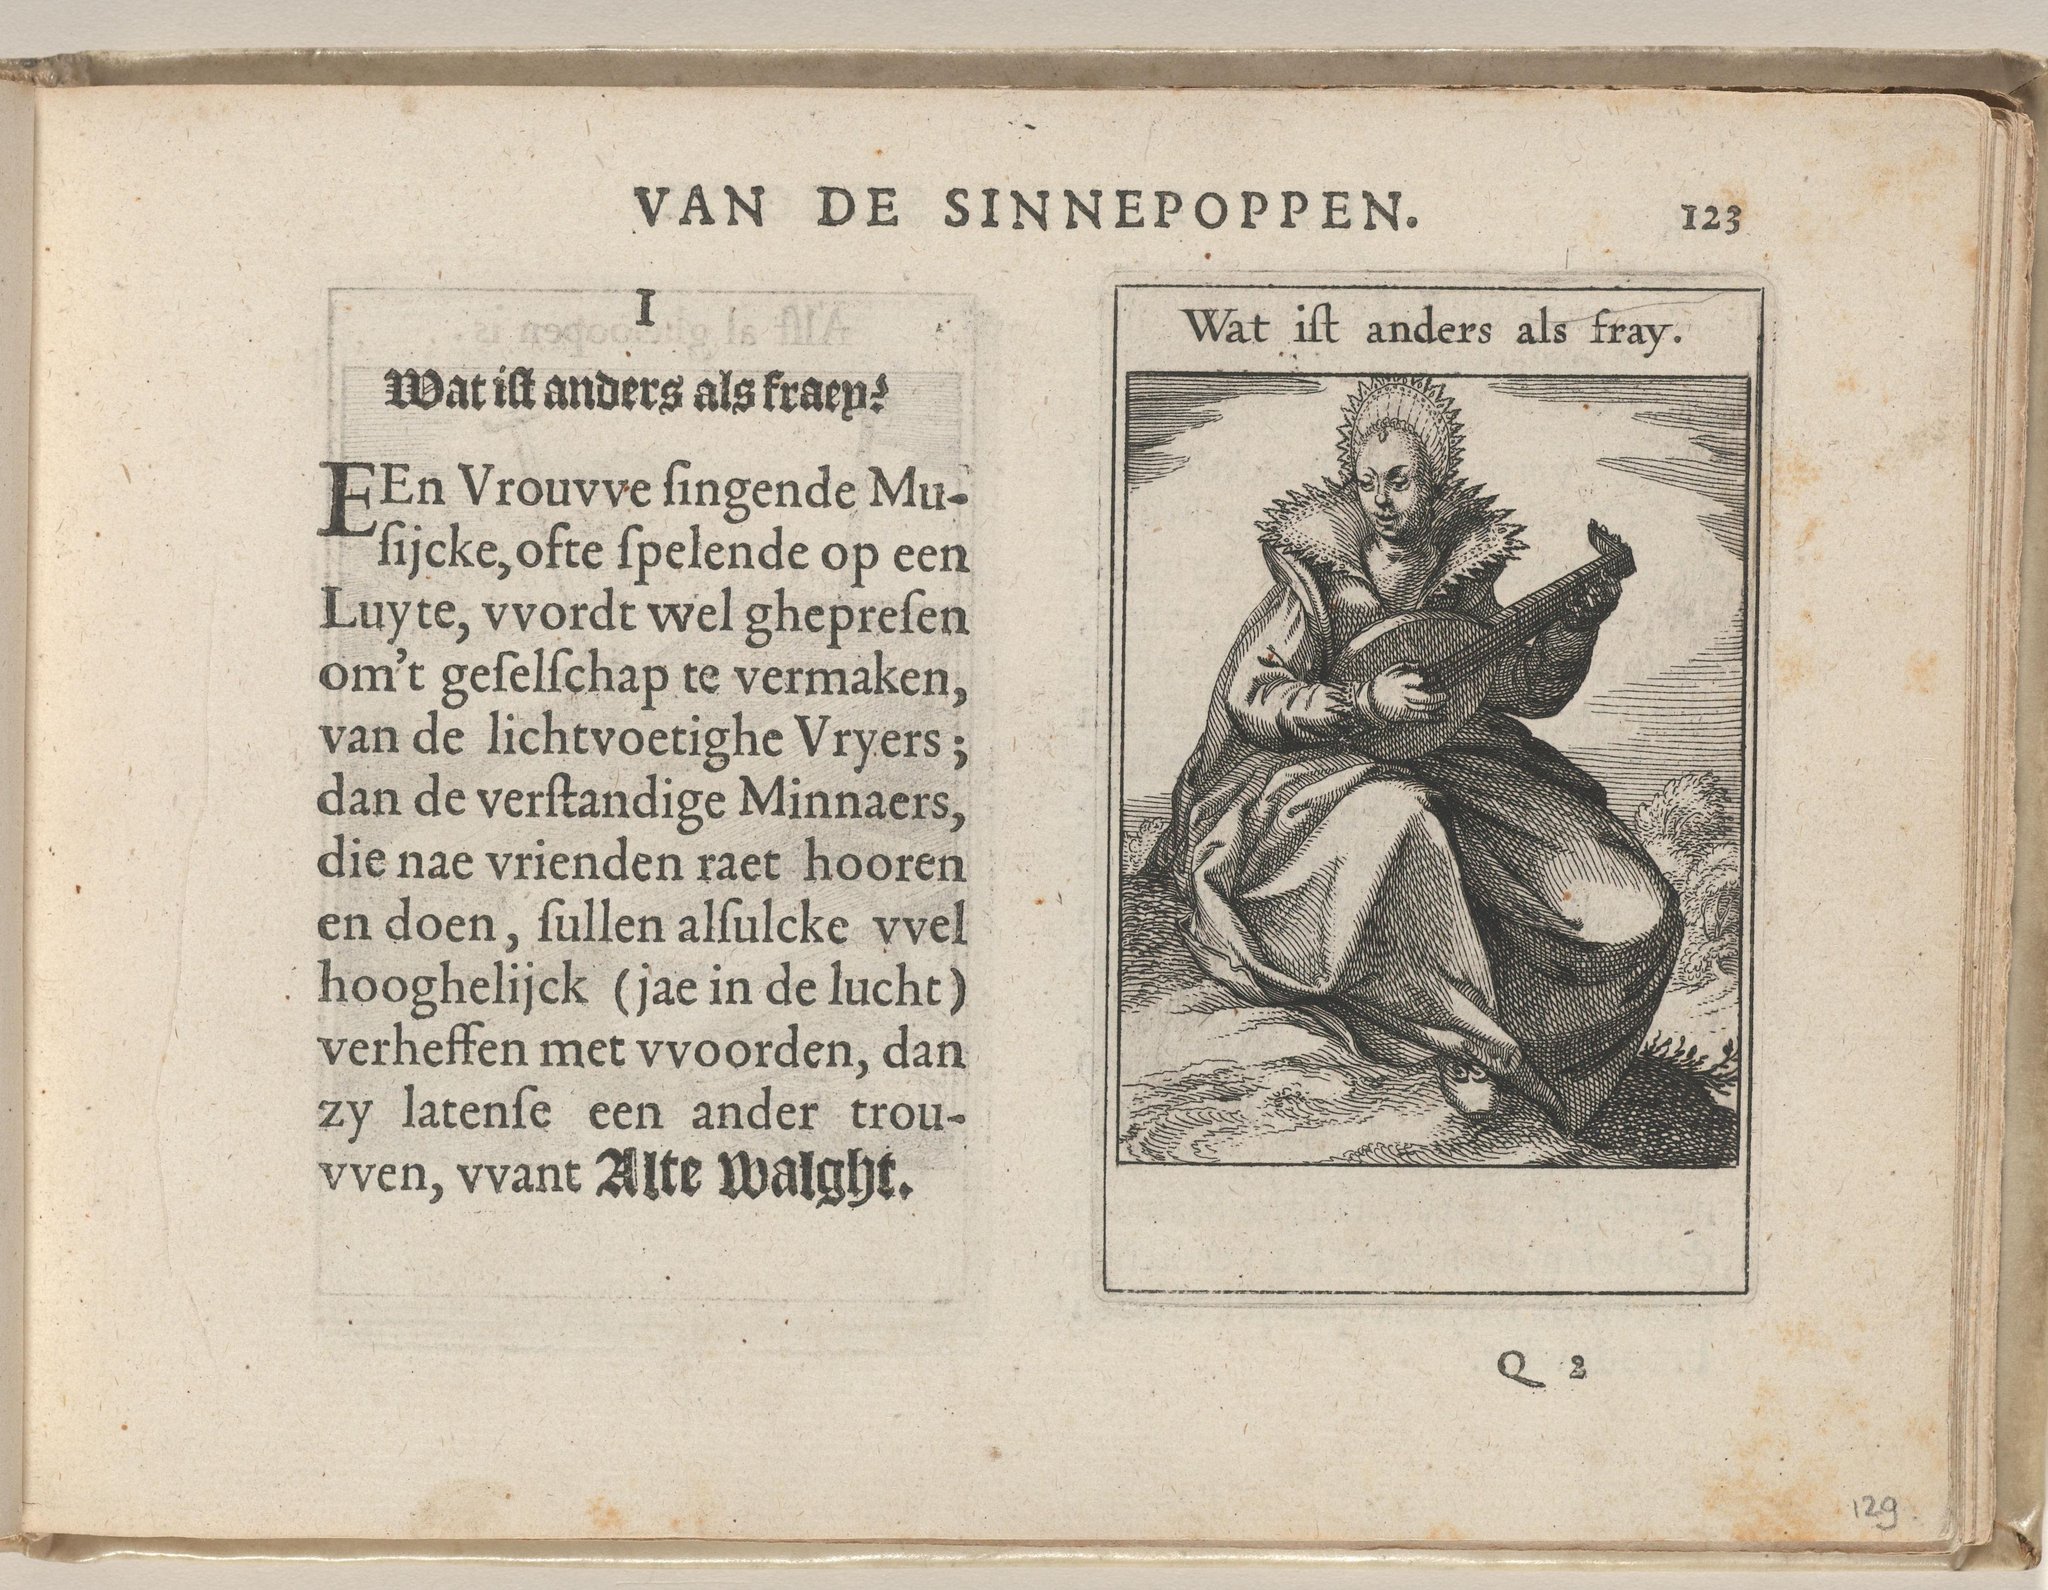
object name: album leaf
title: I Wat ist anders als fray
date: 1614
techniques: engraving, printing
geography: amsterdam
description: I Wat ist anders als fray. Derde schok. Onderdeel van 'Sinnepoppen', R. Visscher, 1614.